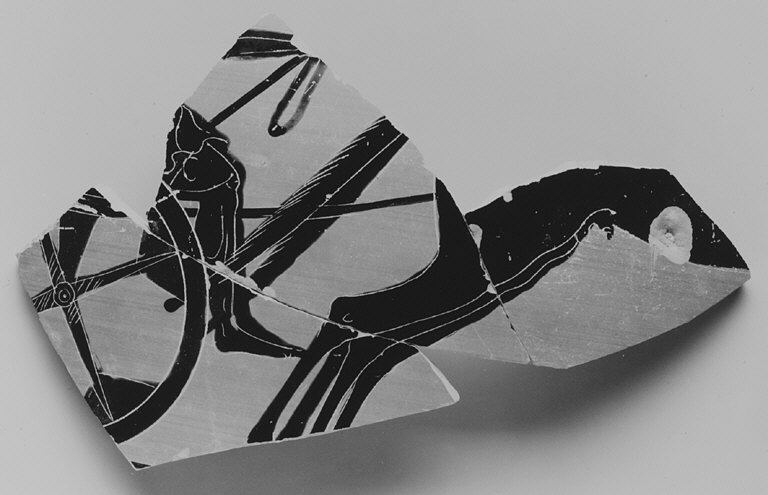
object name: panathenaic prize amphora fragment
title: Two fragments of a Panathenaic prize amphora (jar)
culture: greek, attic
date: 534-468 BCE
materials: terracotta